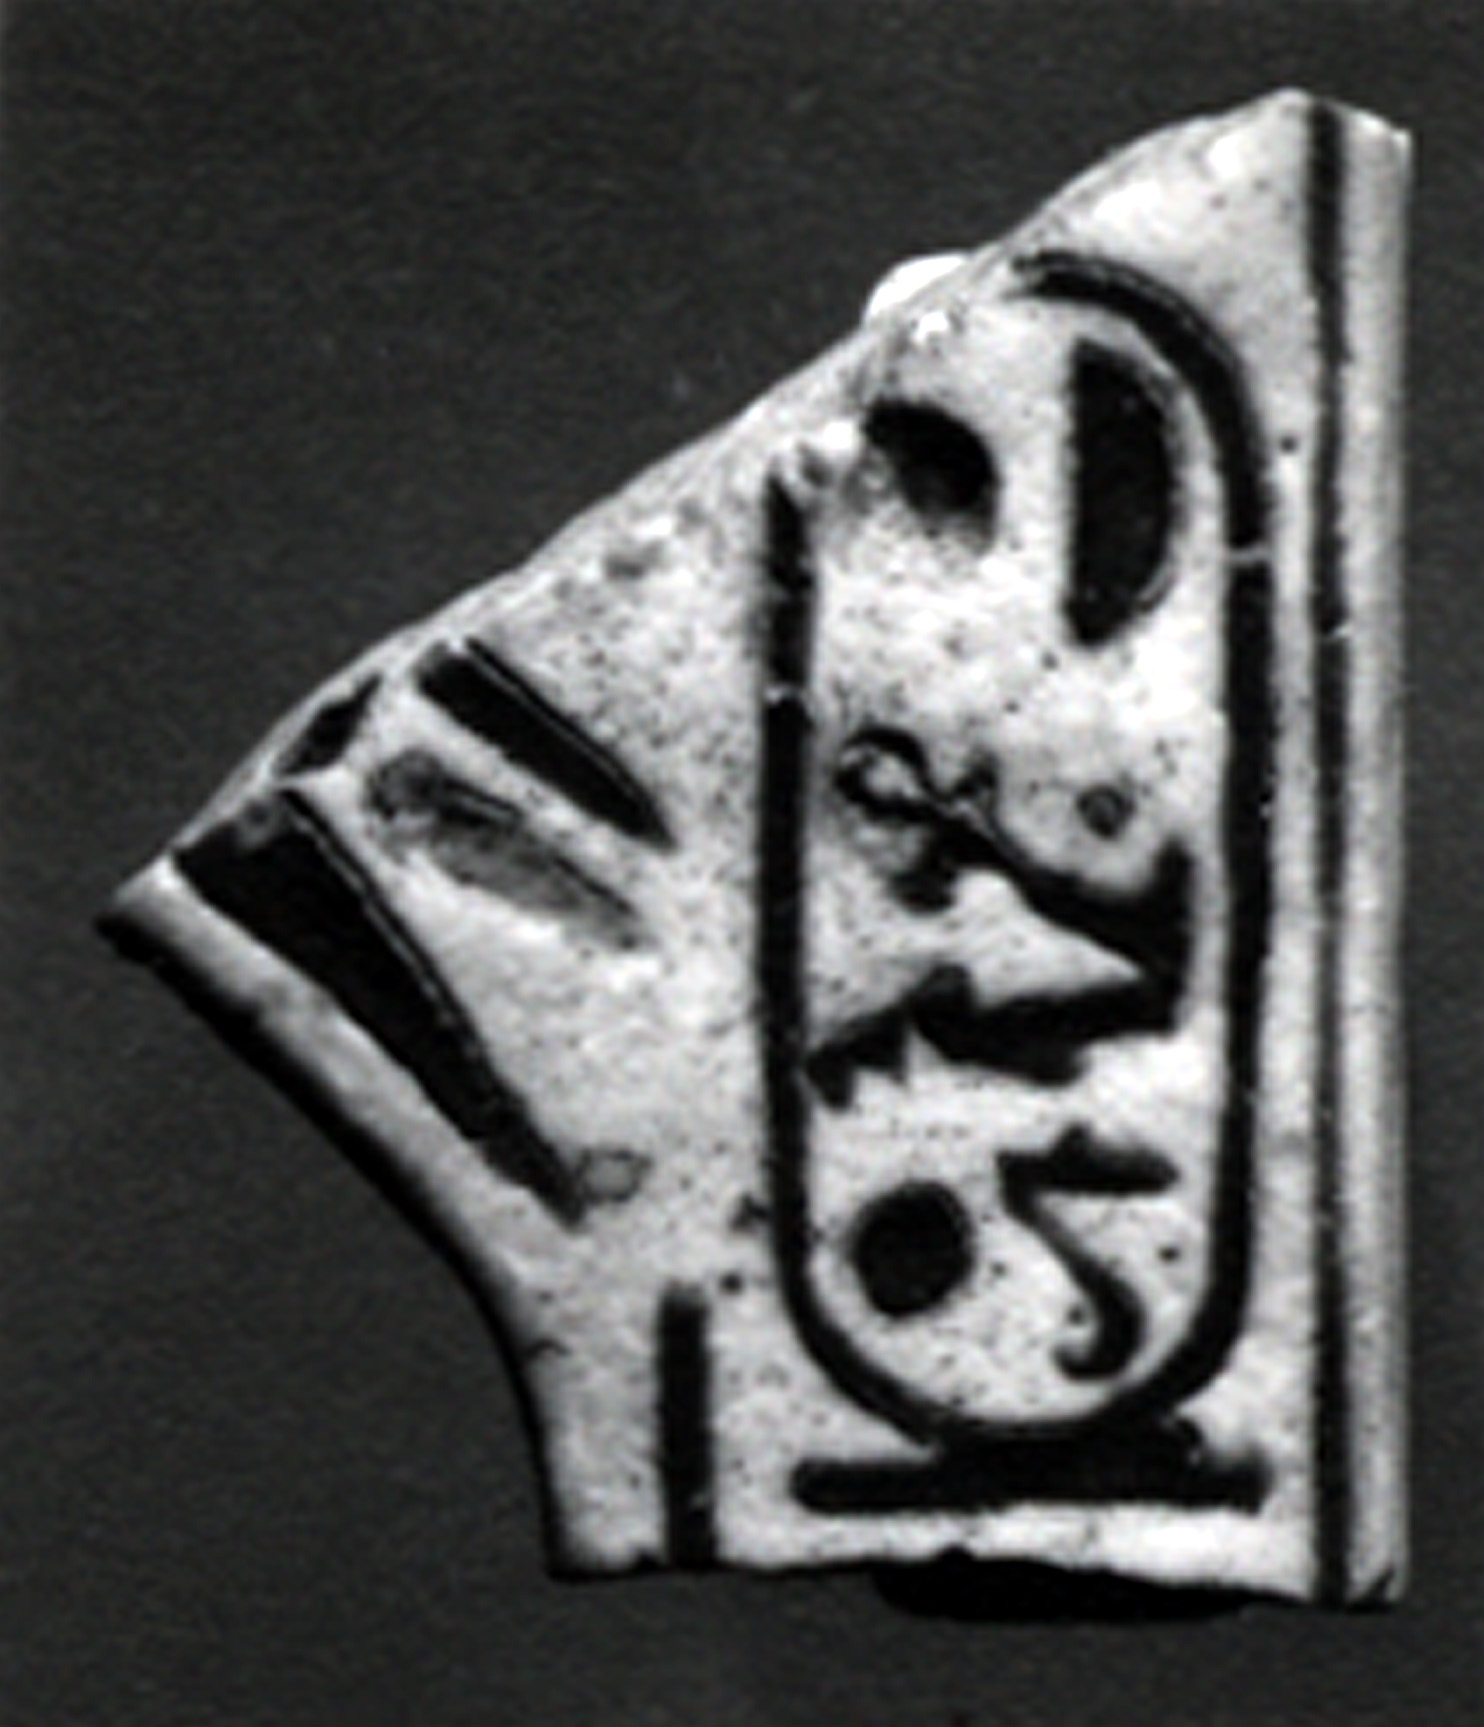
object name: broad collar terminal, cartouche, nebmaatre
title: Broad Collar Terminal with the Cartouche of Nebmaatre (Amenhotep III)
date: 1390-1353 BCE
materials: faience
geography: egypt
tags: cartouches